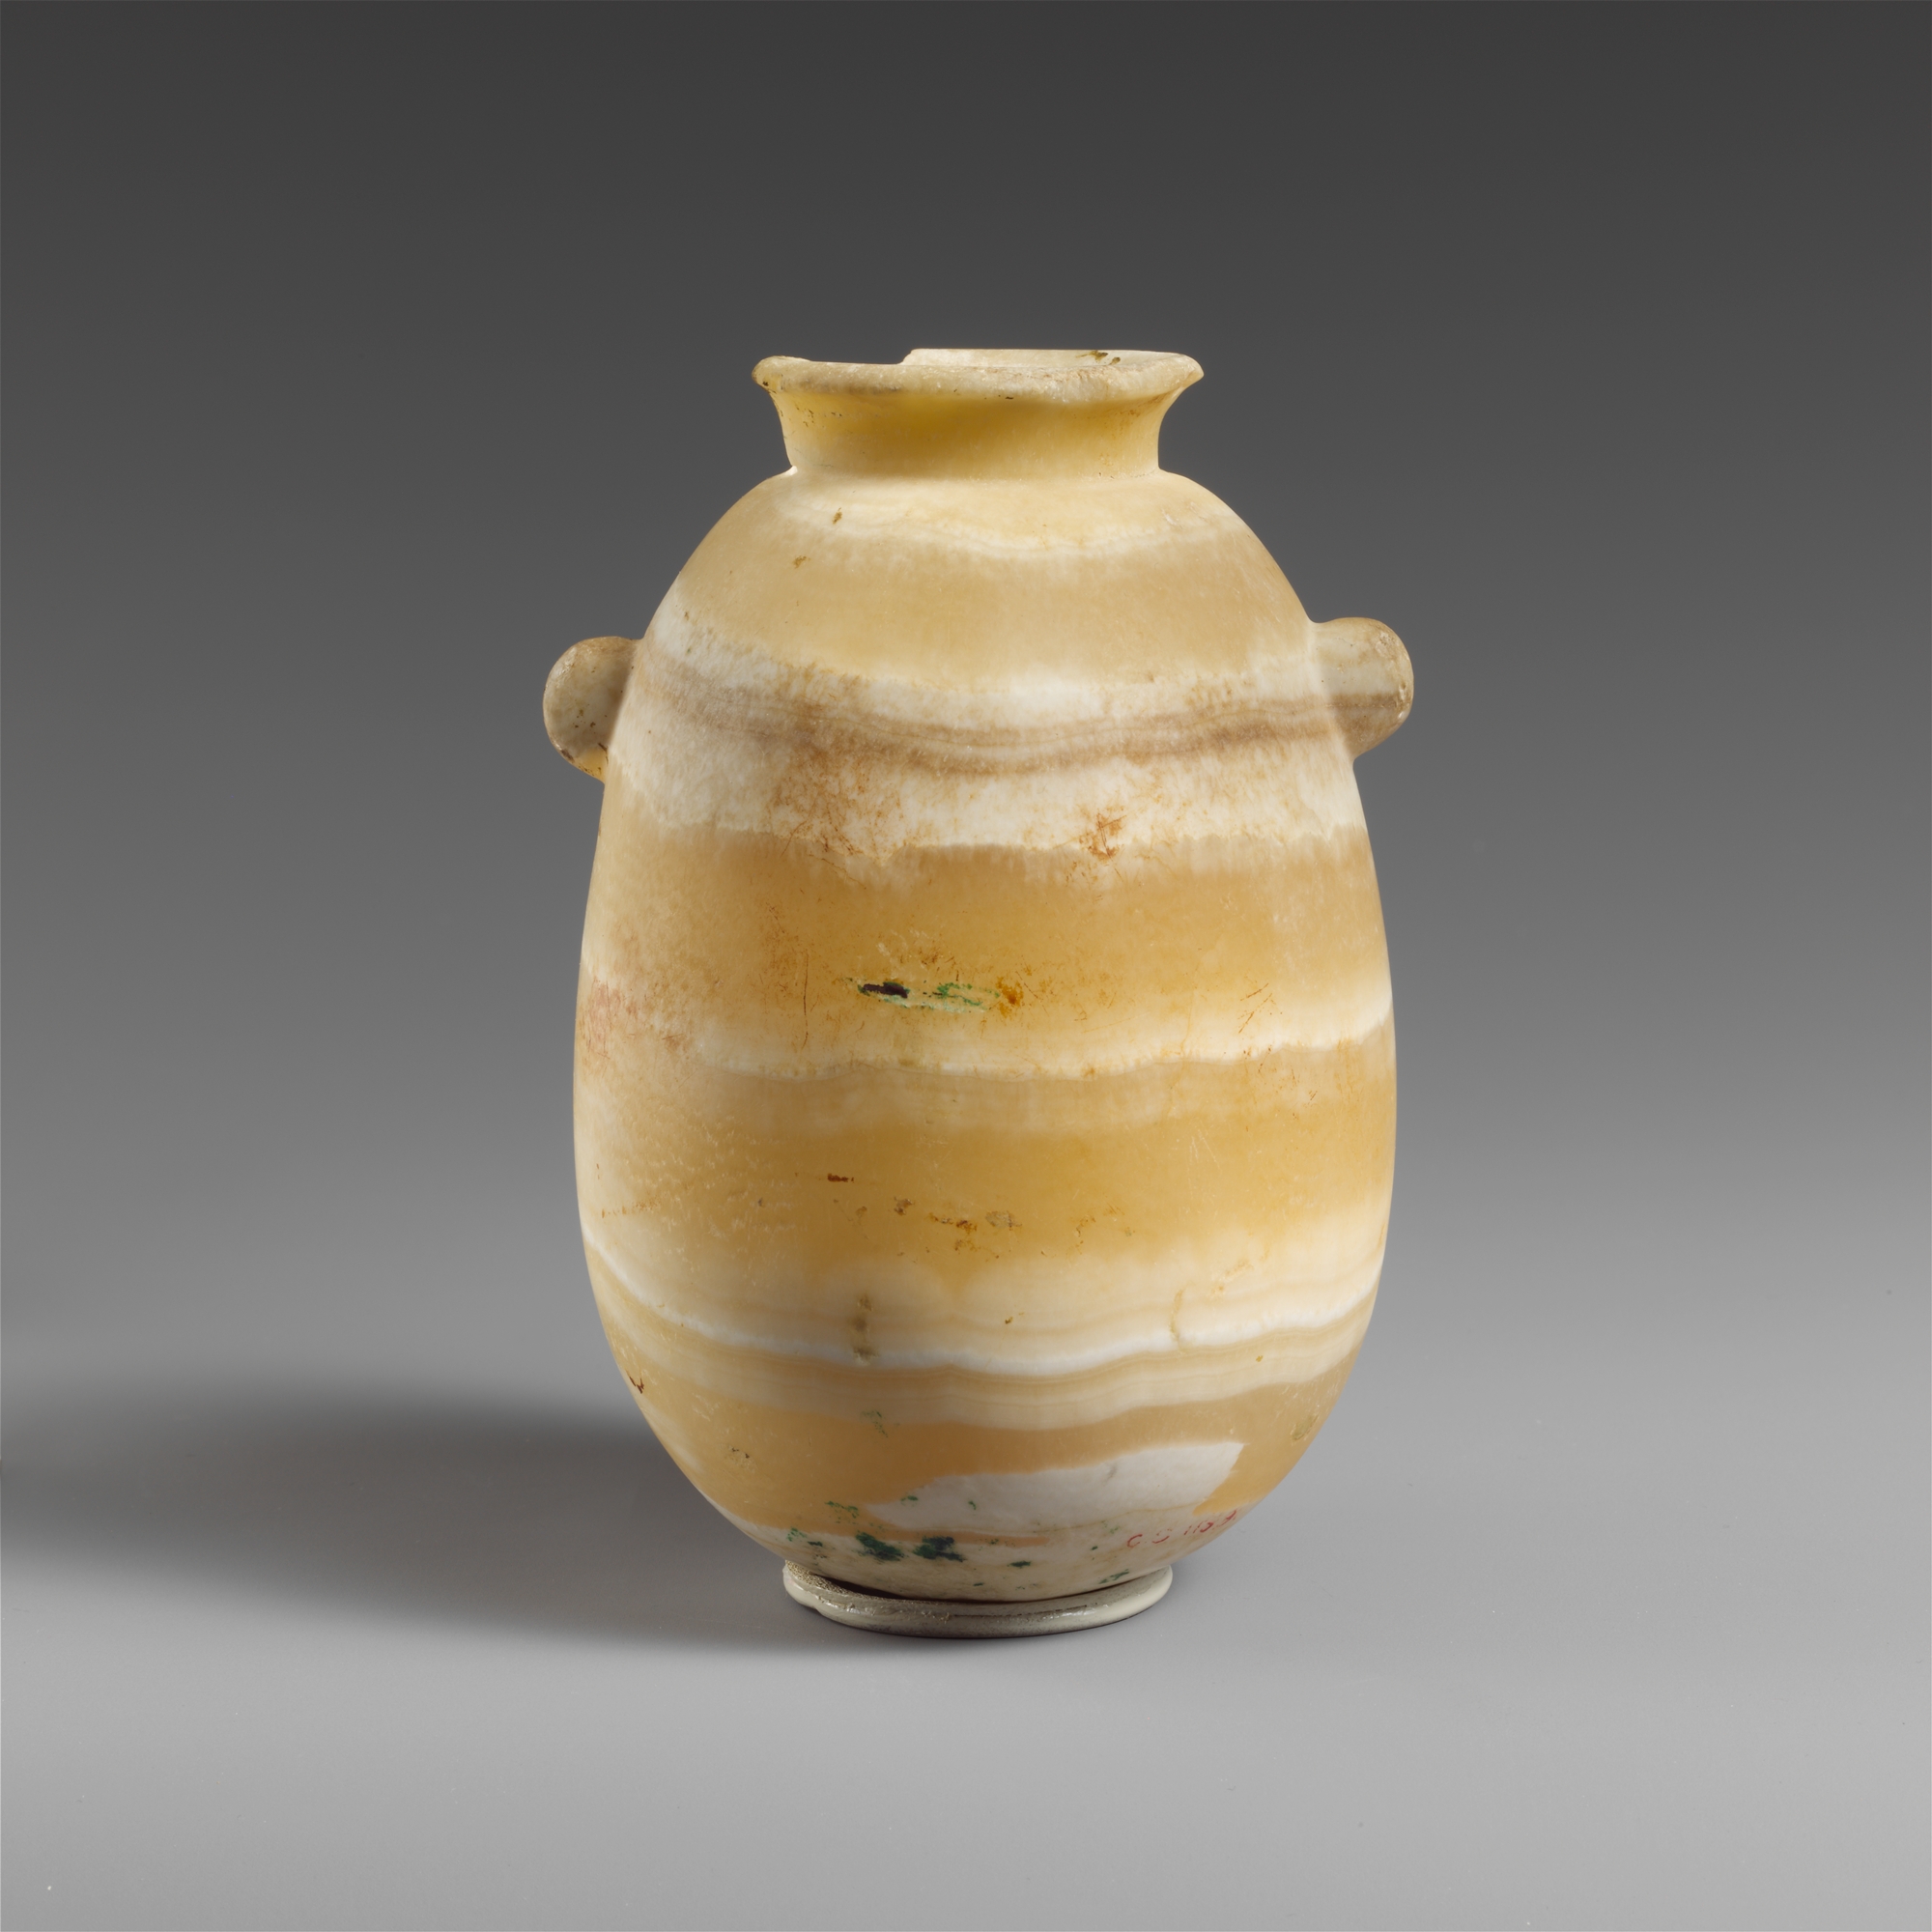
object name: alabastron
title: Alabaster alabastron (perfume vase)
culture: cypriot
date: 600-401 BCE